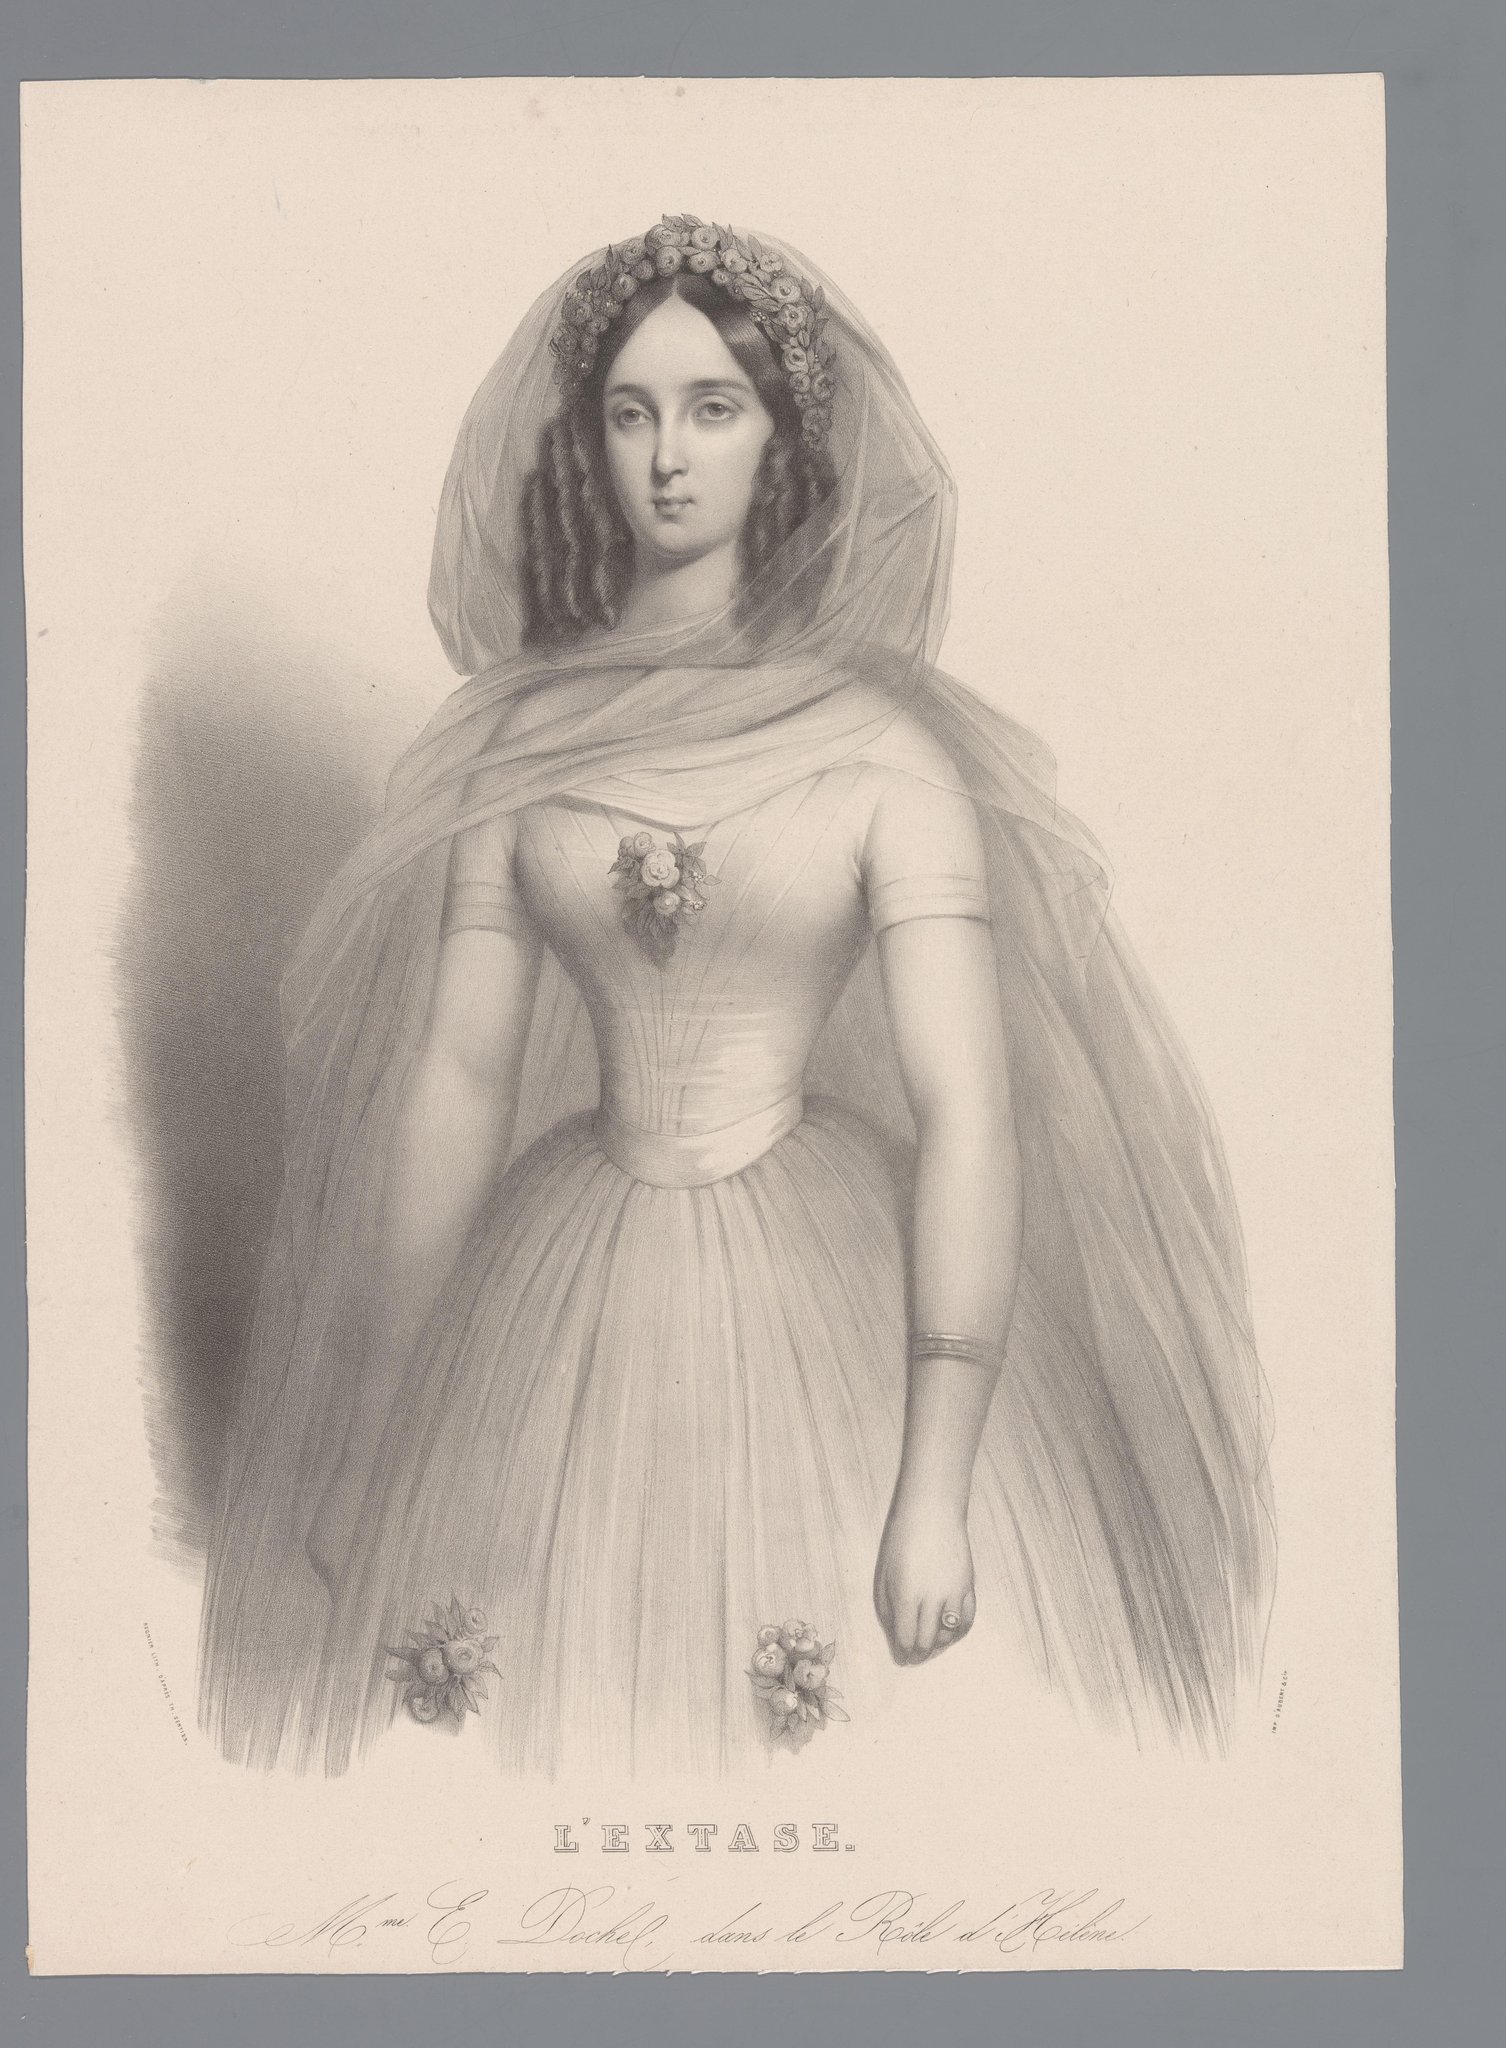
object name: print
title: Portret van actrice Eugénie Doche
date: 1843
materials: paper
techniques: lithograph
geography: paris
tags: historical persons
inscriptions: collector's mark: Lugt 2228